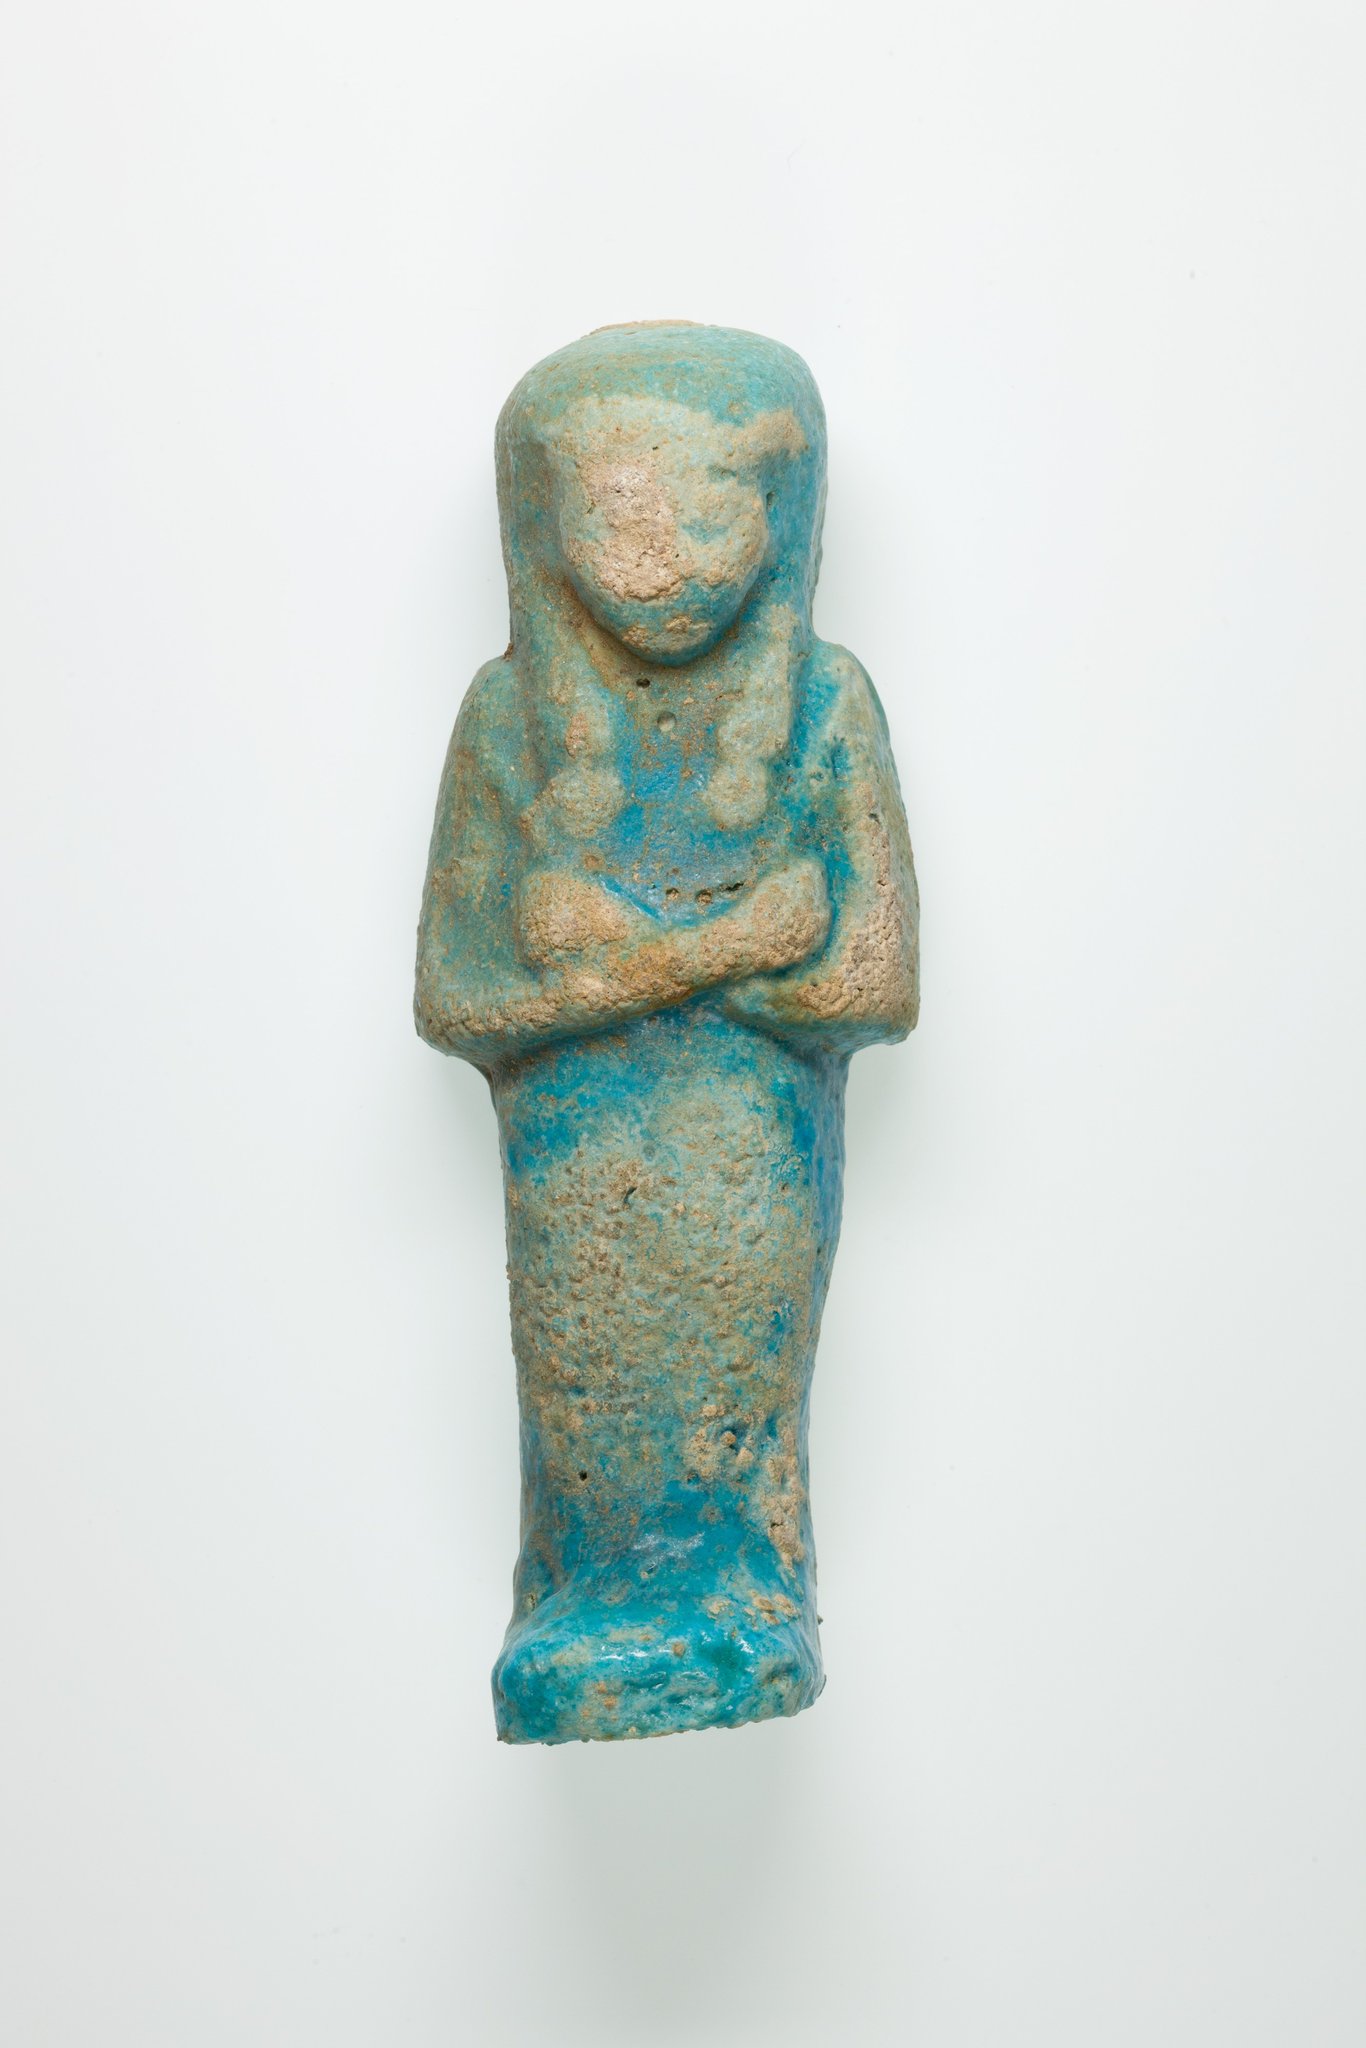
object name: worker shabti, henettawy c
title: Worker Shabti of Henettawy (C), Daughter of Isetemkheb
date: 990-970 BCE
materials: faience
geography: egypt